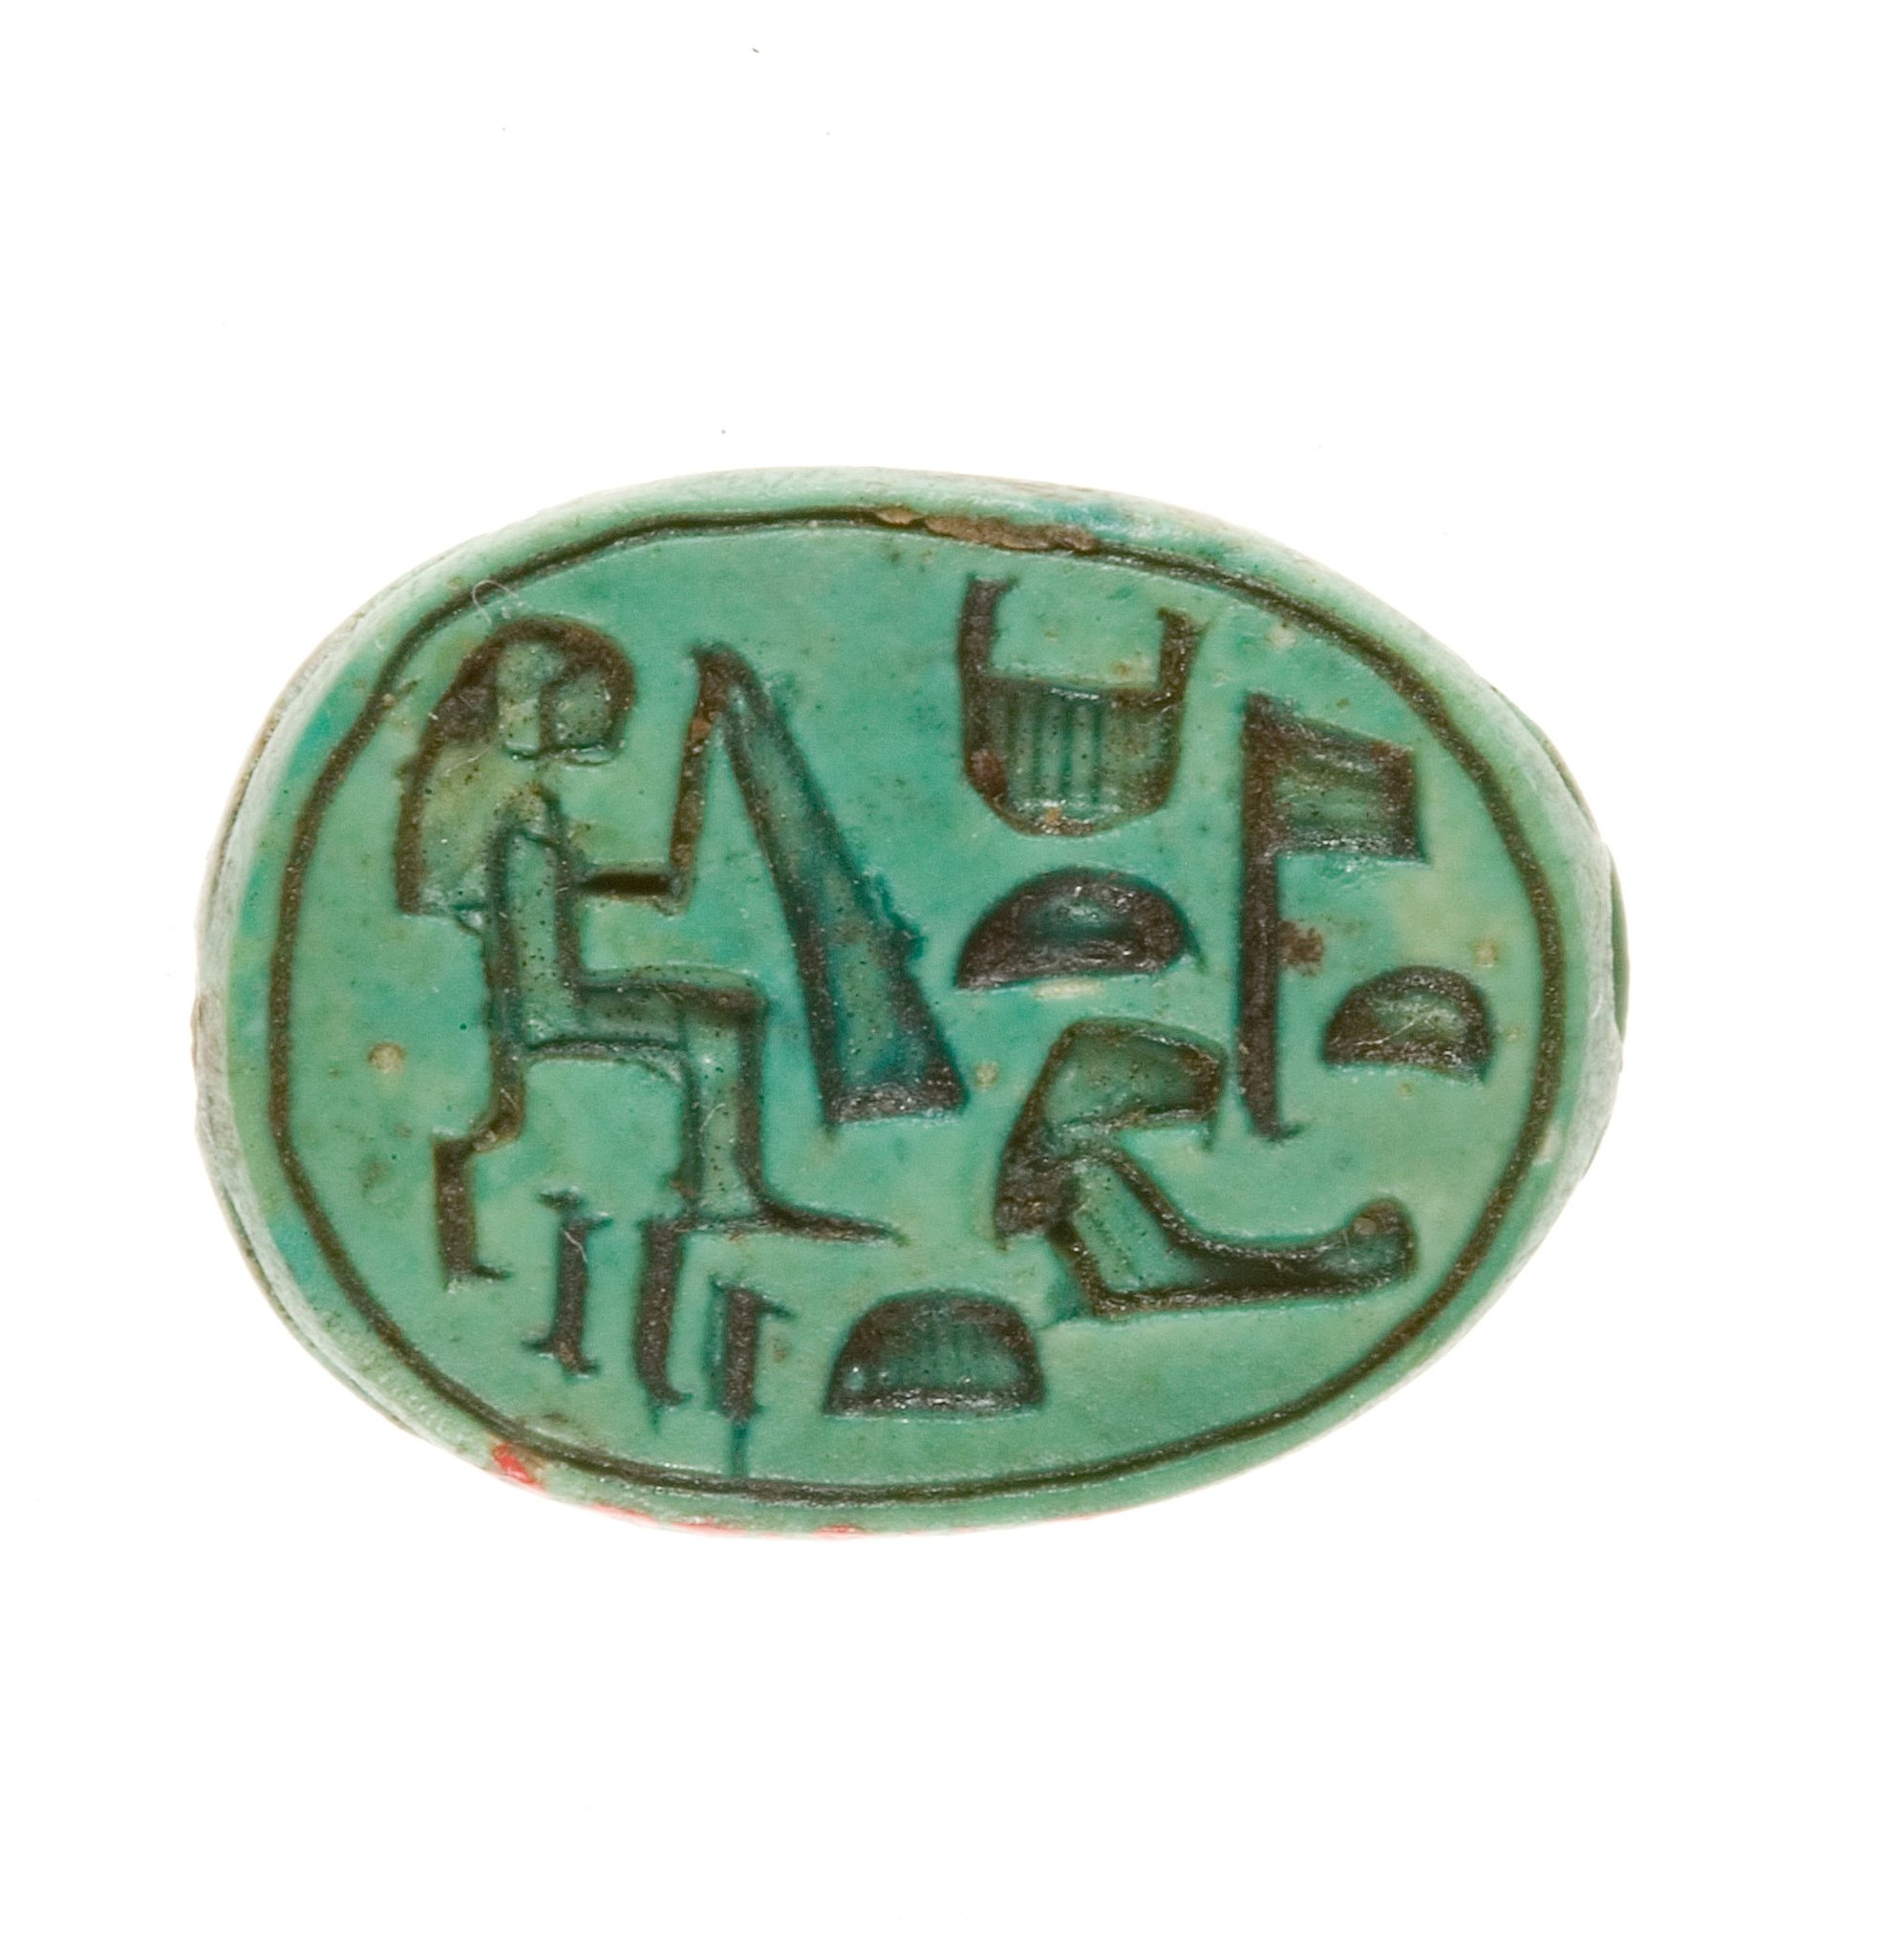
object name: scarab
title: Scarab Inscribed for the God's Wife Hatshepsut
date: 1479-1458 BCE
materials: stone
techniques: glazing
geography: egypt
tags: hieroglyphs,scarabs